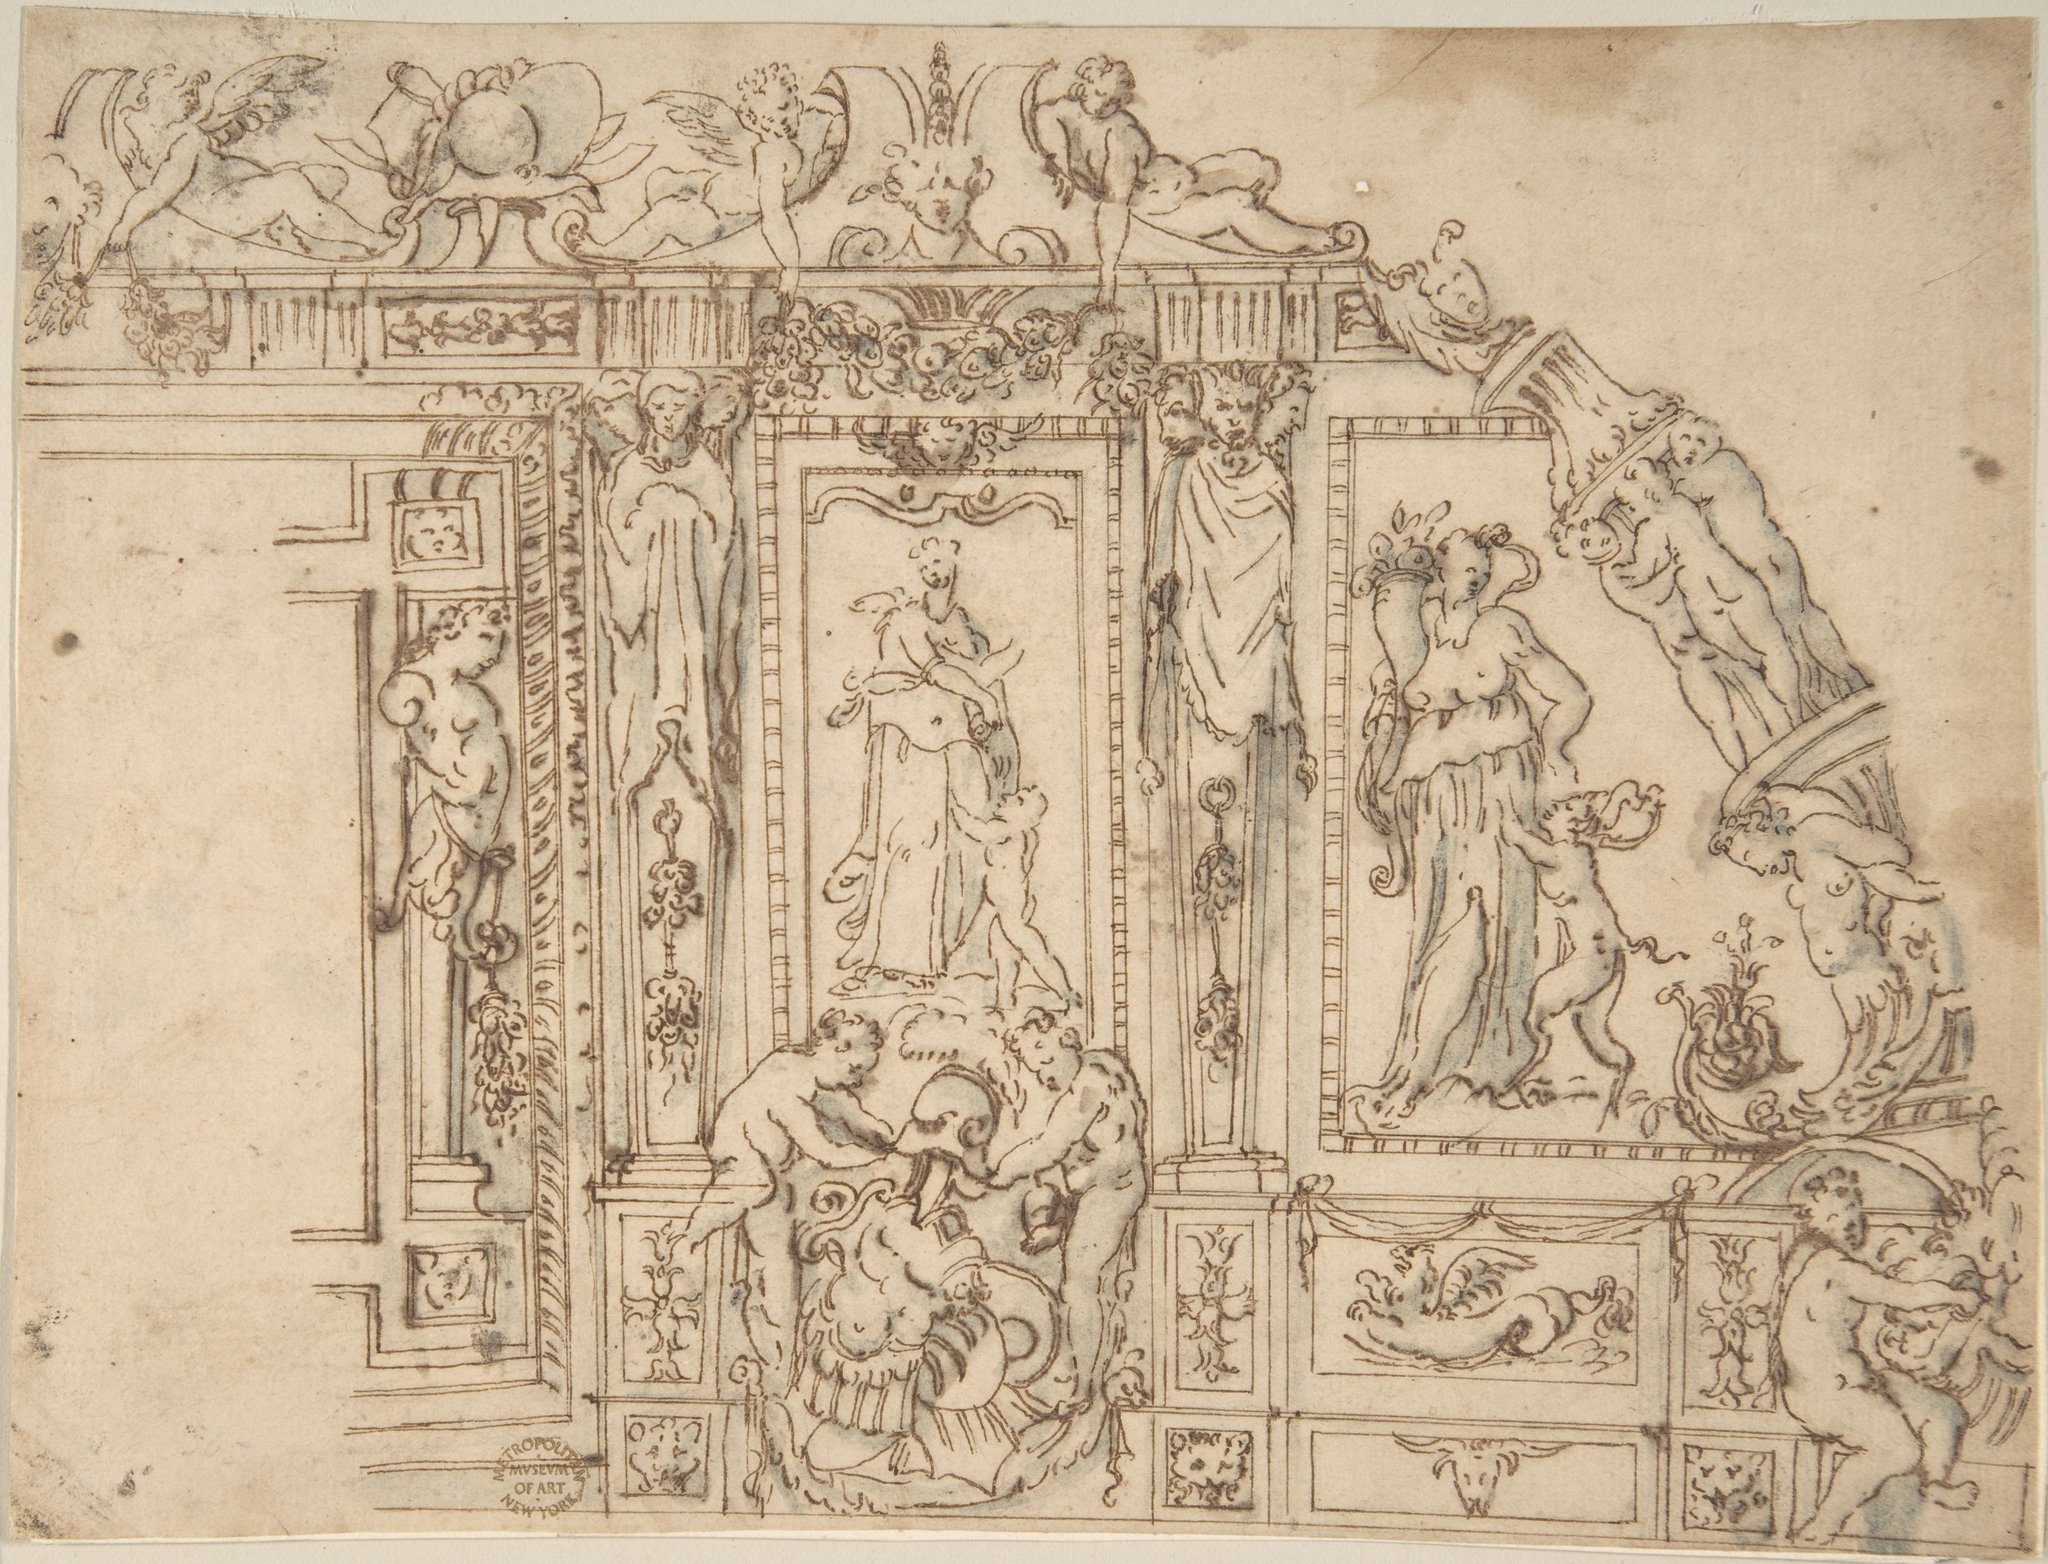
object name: collection ornament architecture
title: Sketch for Wall Decoration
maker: anonymous, italian, 16th century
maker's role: artist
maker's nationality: italian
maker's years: 1550-1600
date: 1540-1580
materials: ink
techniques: pen, wash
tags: ornament